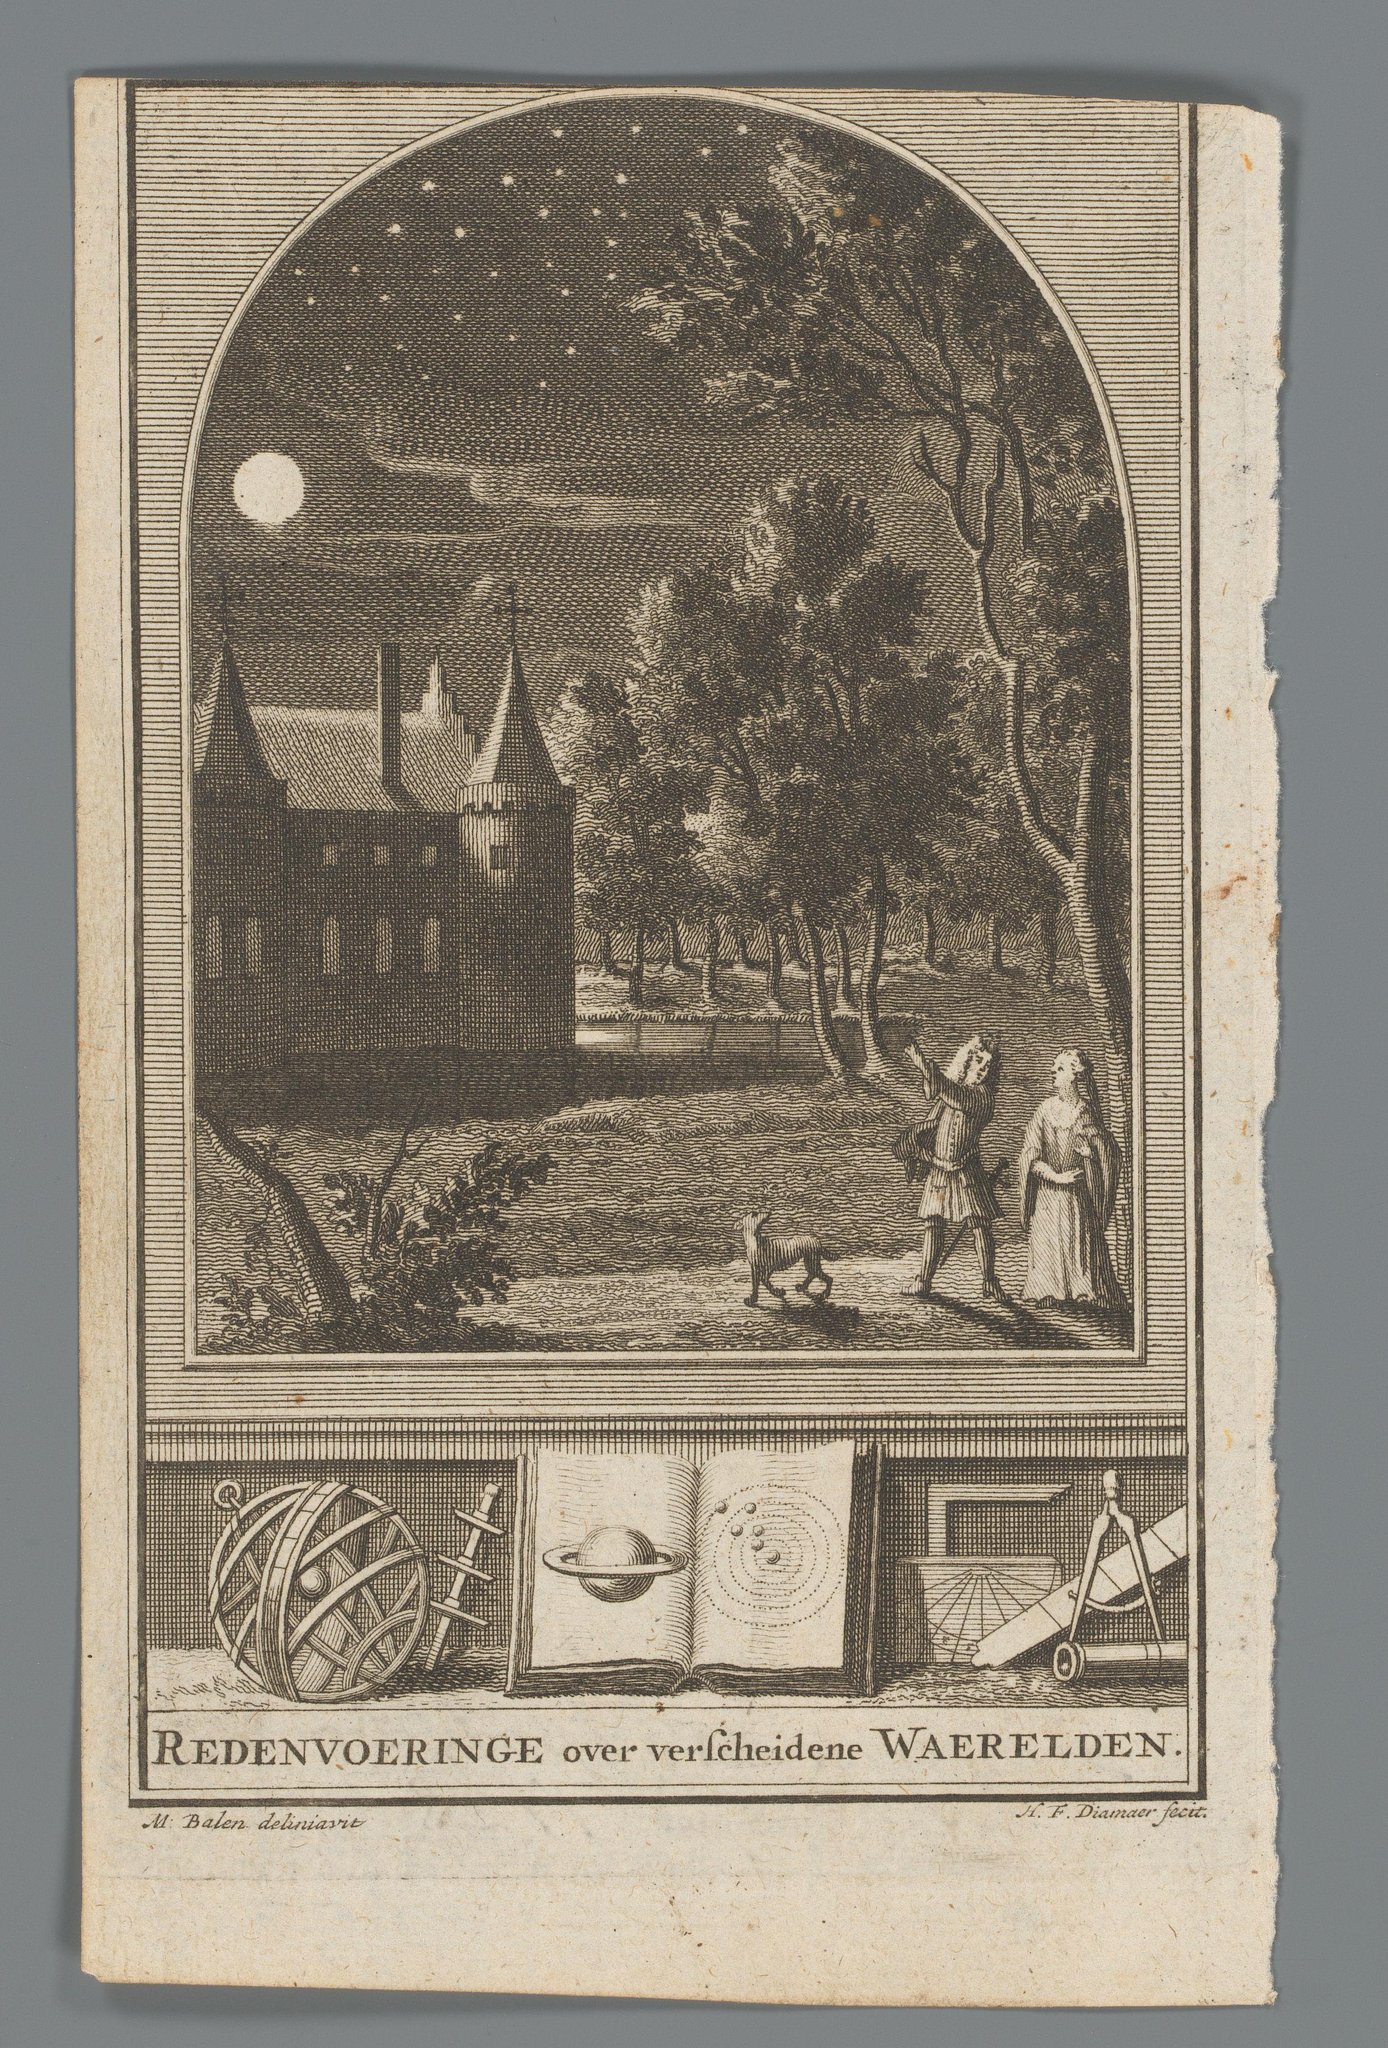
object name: print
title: Twee mensen wandelen 's nachts langs een kasteel en bekijken de hemel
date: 1728-1753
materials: paper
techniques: engraving, etching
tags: castle, astronomical instruments, moon as celestial body, astronomy (and cosmography)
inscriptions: inscription: ‘Titelplaatje/ Reden-voeringe/ over verscheiden/ Waerelden/ in't/ Geheel-al (...) tweede druk/ te/ Dordrecht by/ Hendrik Walpot, boek/ verkooper 1728’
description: Prent voor het eerst gebruikt in: Le Bovier de Fontenelle, Bernard. Reden-voeringe over verscheidene waerelden, in't geheel-al. Dordrecht: Hendrik Walpot, 1728. Prent opnieuw gebruikt in 1753-uitgave van dit boek.